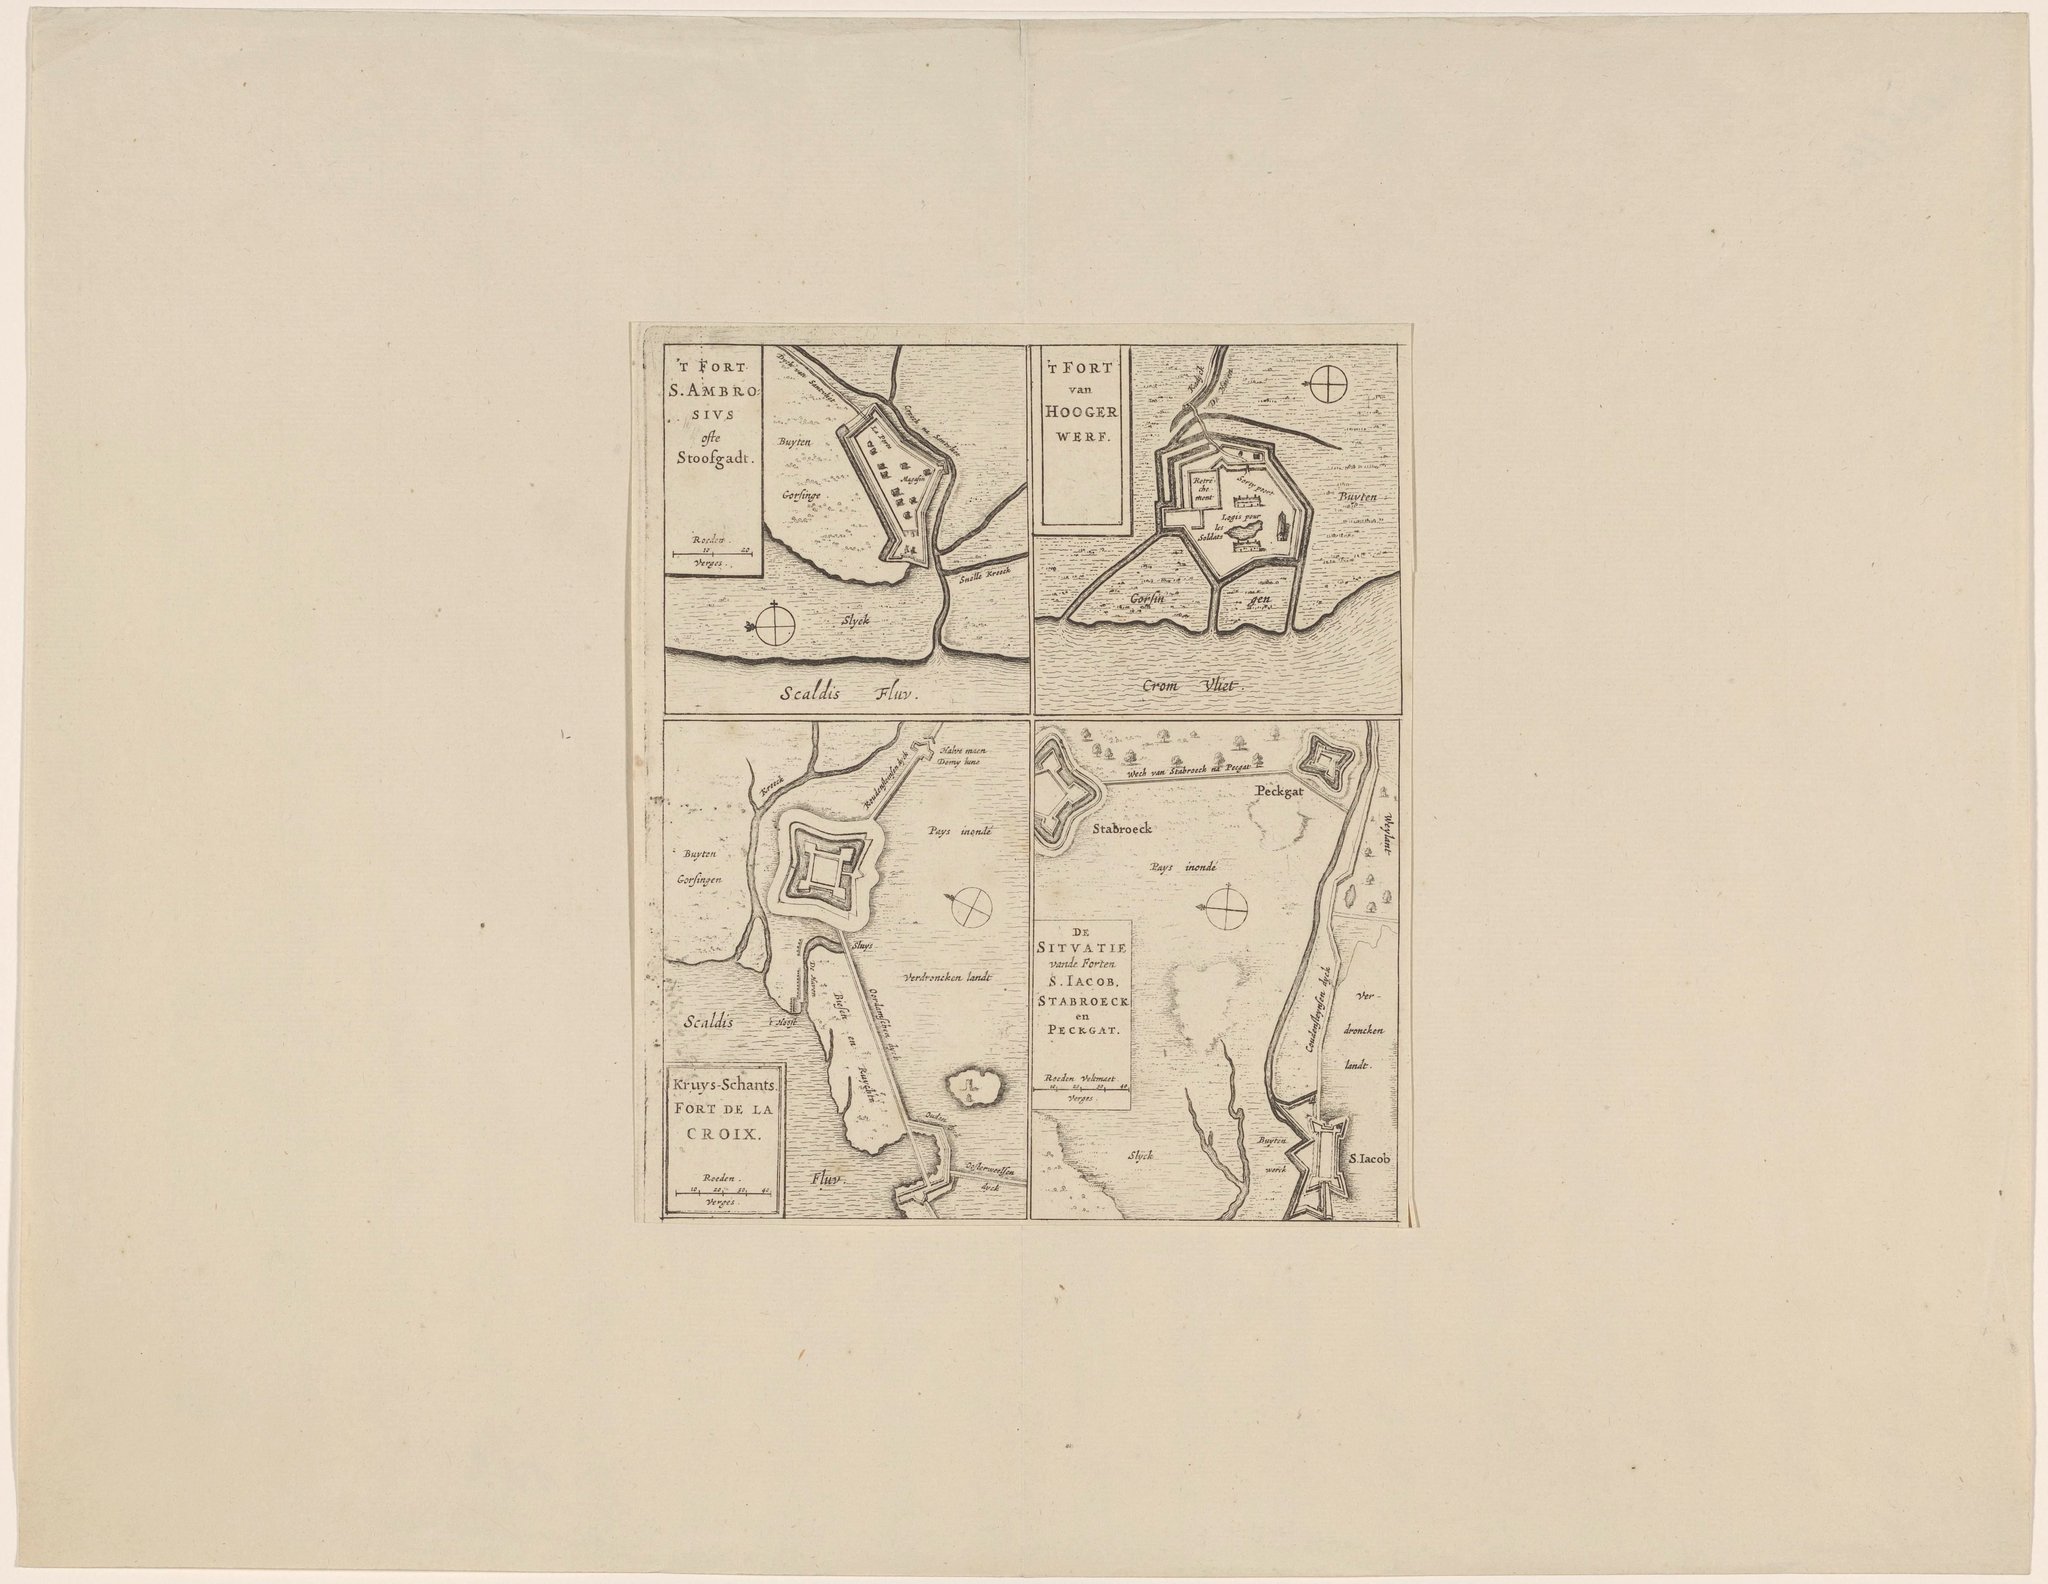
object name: area plan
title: Vestingplattegronden van Fort Sint-Ambrosius, Fort Sint-Martijn, de Kruisdijkschans, Fort Sint-Jacob, Fort Stabroek, Fort van Pekgat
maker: Anonymous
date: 1649-1728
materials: paper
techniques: engraving, etching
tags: fortified city, zeeland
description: Deze prent is ook gebruikt in Stedenboeken van Blaeu, atlassen van De Wit en Galérie Agréable du Monde van Van der Aa. Uit welke publicatie deze prent afkomstig is, is niet na te gaan. Hier is aan de onderkant een deel van de prent afgesneden, aan de rechterkant is wellicht ook een deel afgesneden. Voor een volledige versie zie RP-P-AO-16-52-1 en RP-P-AO-16-23.